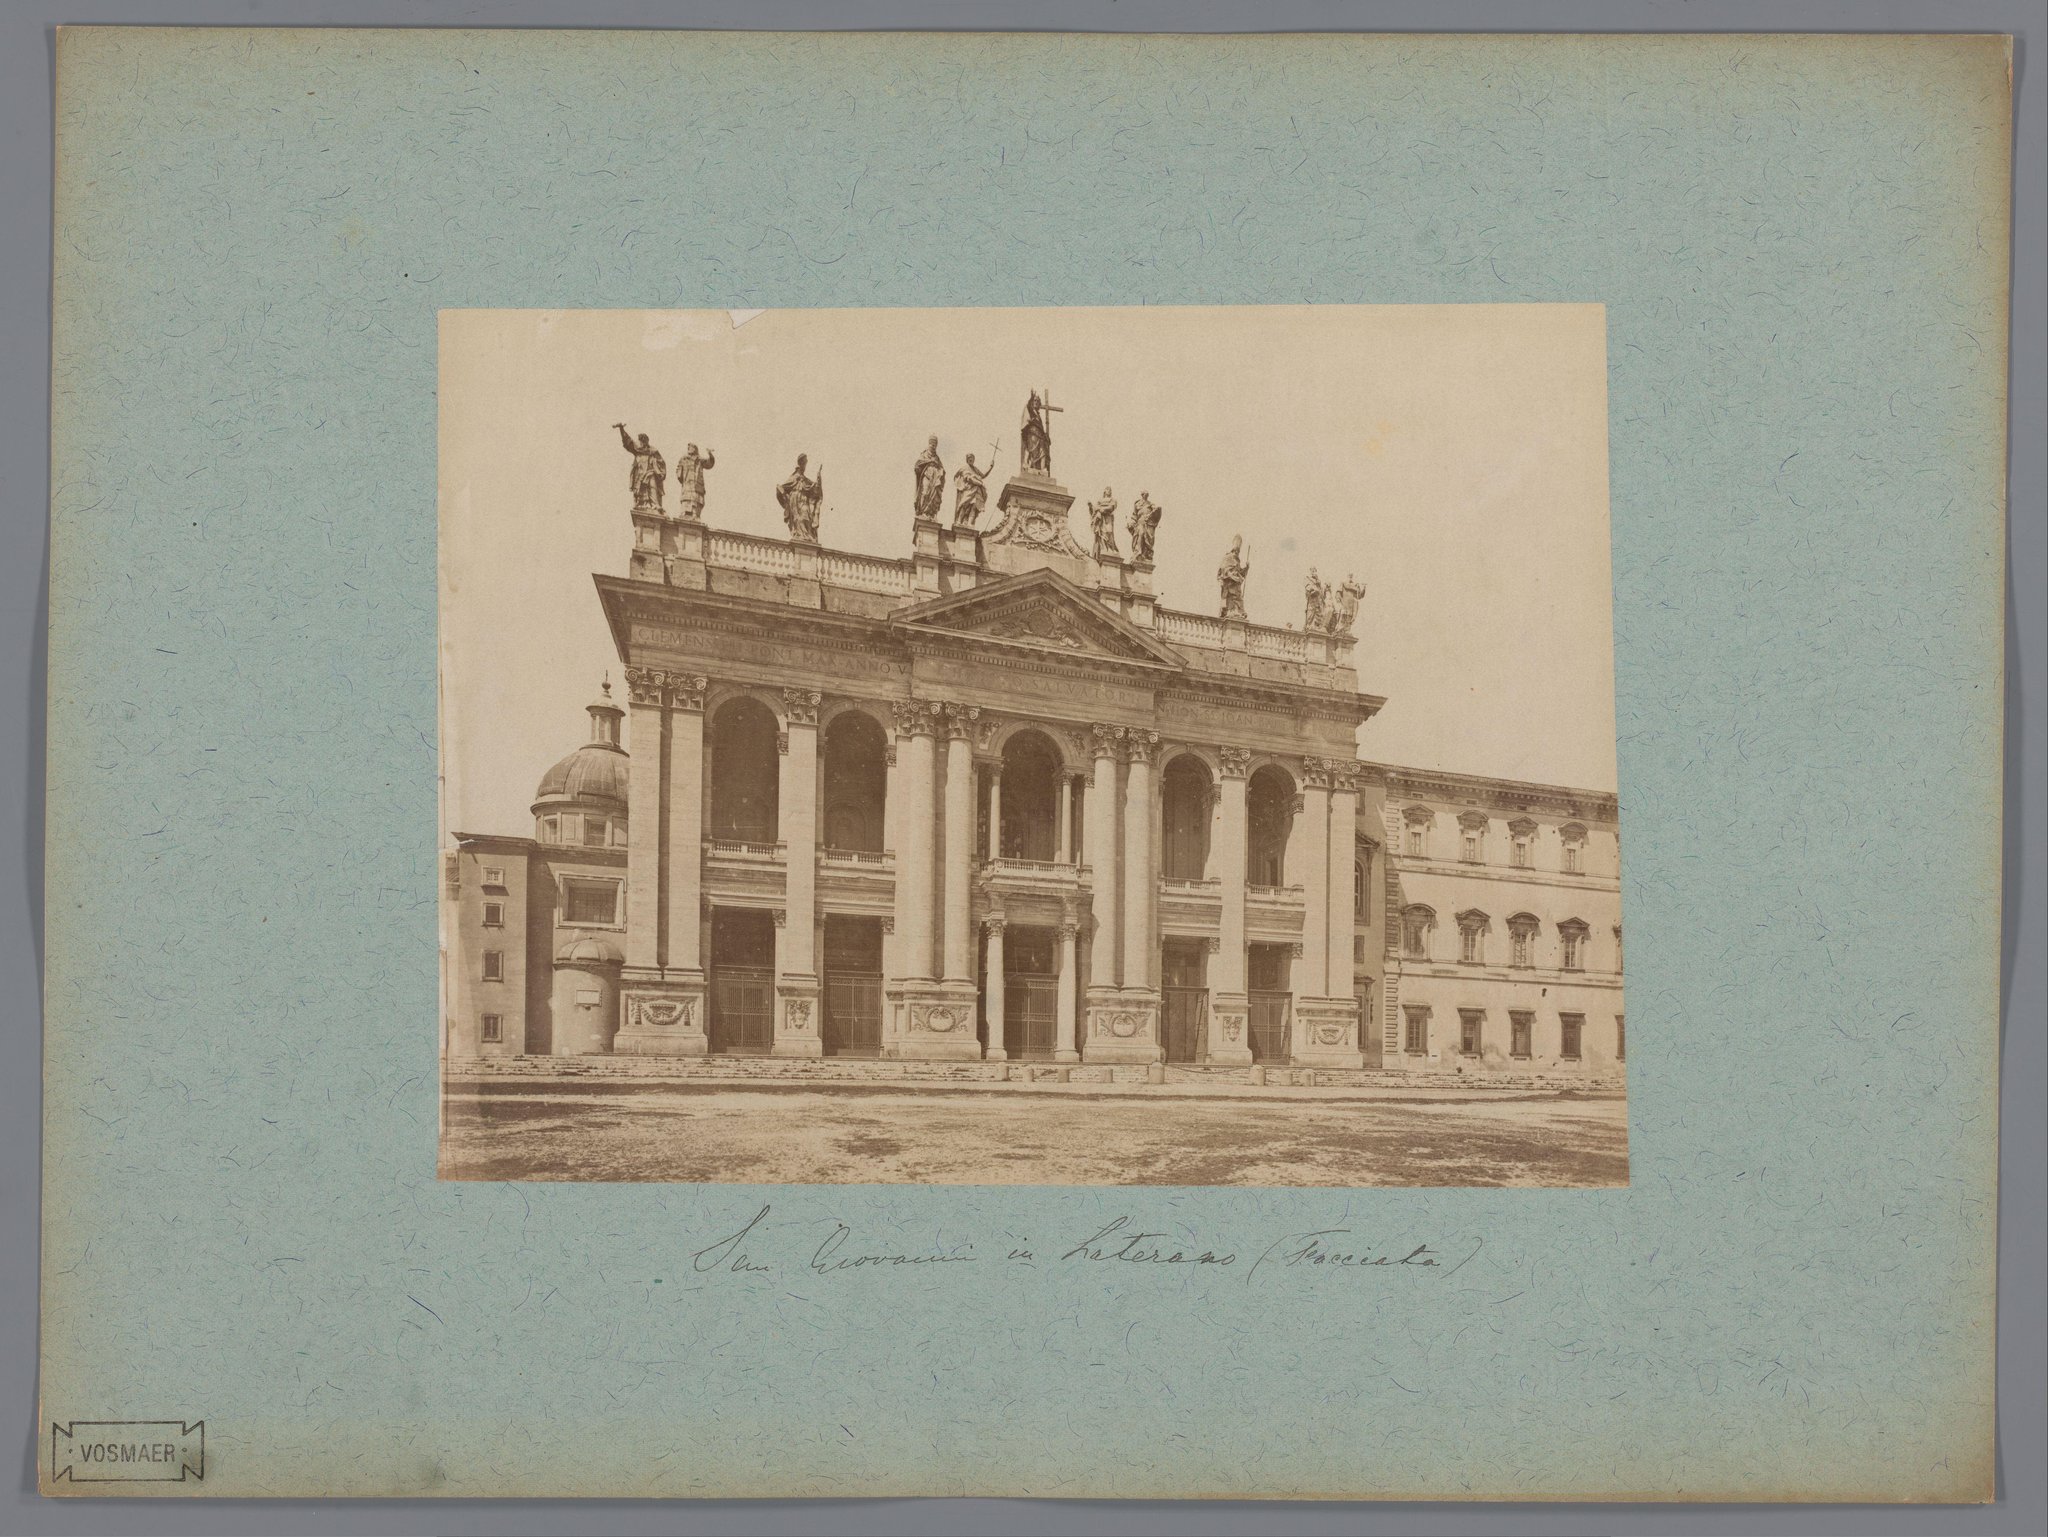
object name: photograph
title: Voorgevel van de Sint-Jan van Lateranen te Rome, Italië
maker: Anonymous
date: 1851-1900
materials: cardboard, paper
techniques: albumen print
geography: rome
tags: church (exterior), rome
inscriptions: collector's mark: ‘VOSMAER’, inscription: ‘Sint Giovanni in Laterano (Facciata)’